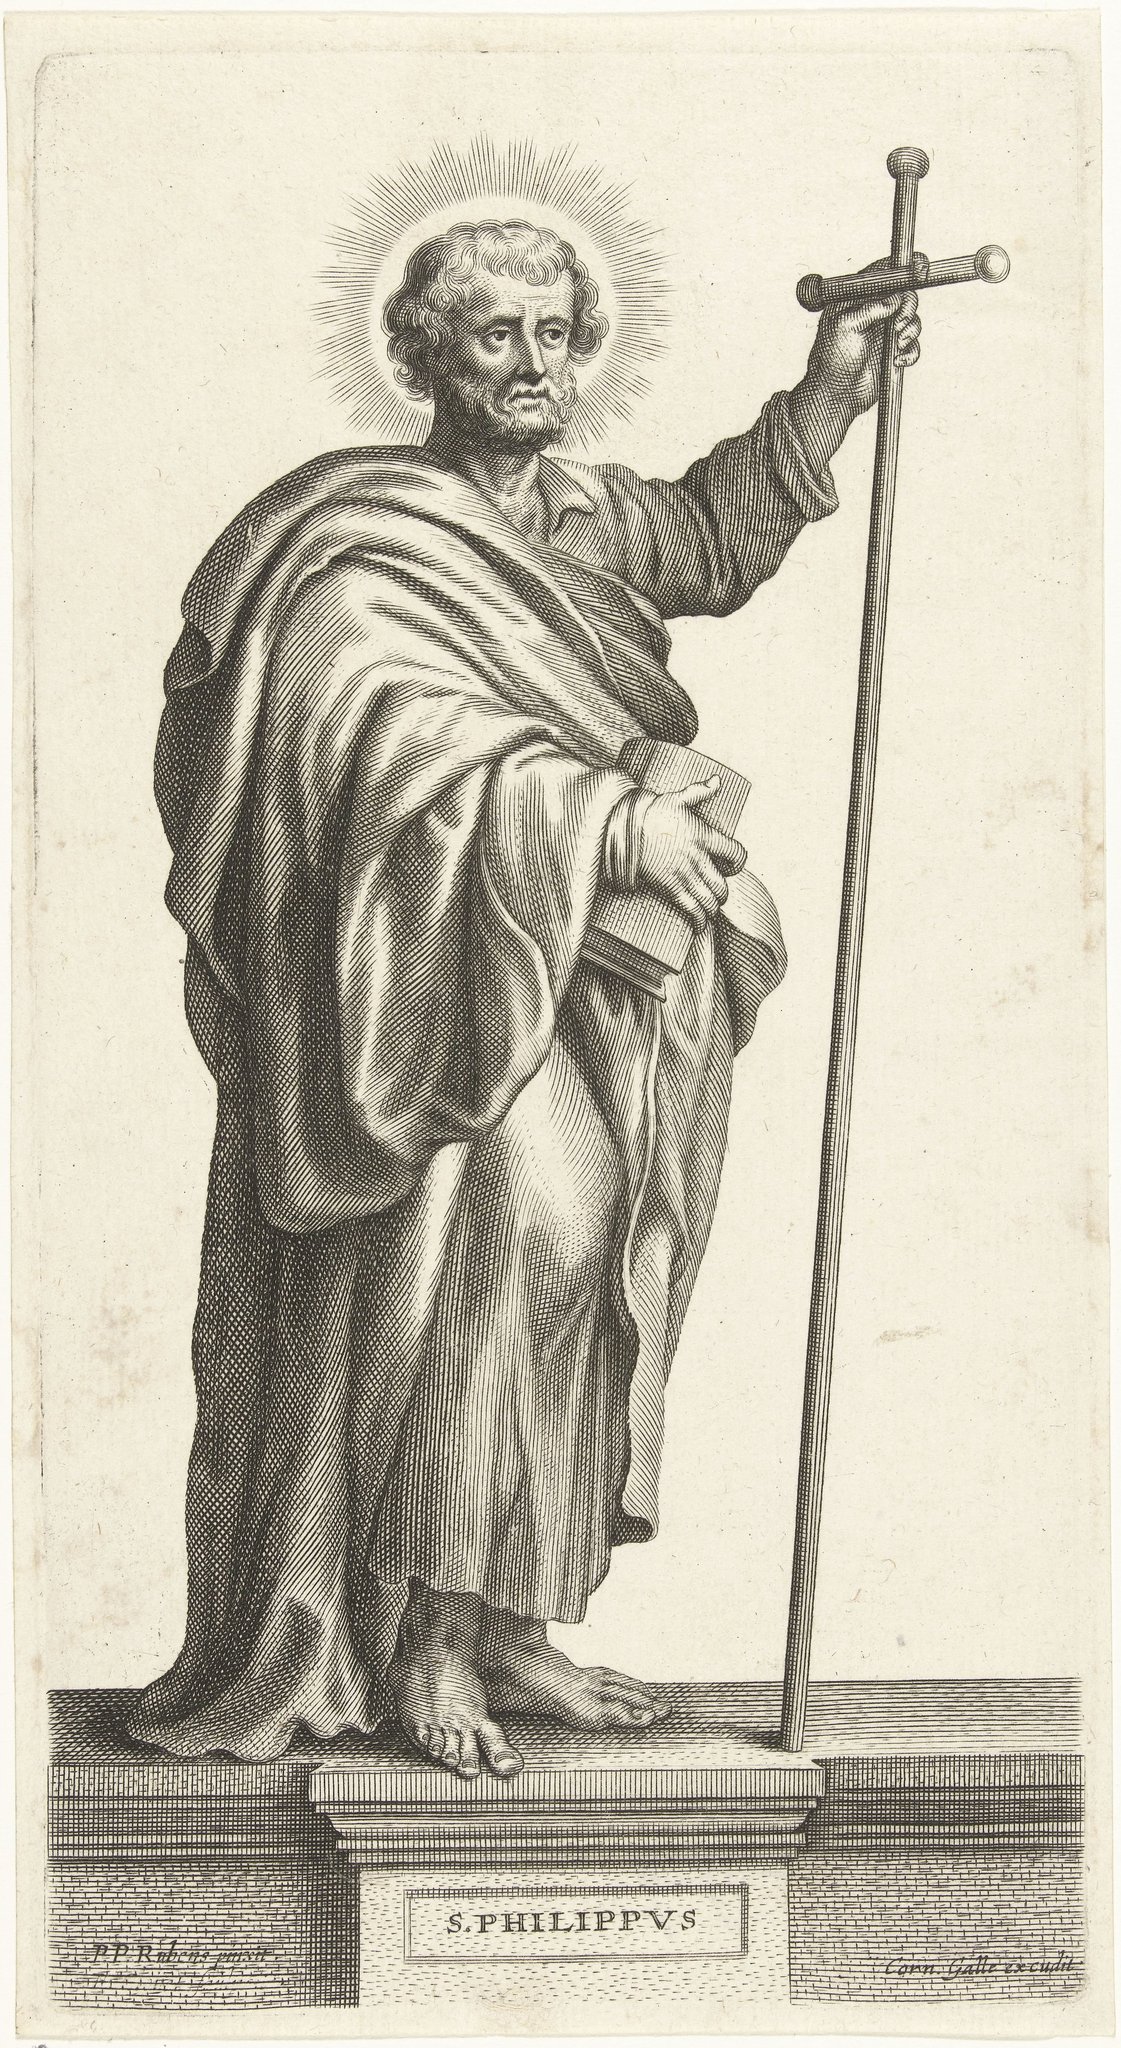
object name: print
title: Heilige Filippus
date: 1639-1670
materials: paper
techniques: engraving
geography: antwerp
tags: the apostle philip; possible attributes: book, cross, dish with snake, lance, scroll, stone, sword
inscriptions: collector's mark: Lugt 240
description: De prent toont de Heilige Filippus. In zijn linkerhand zijn martelwerktuig, het kruis. De serie bestaat uit prenten gebaseerd op schilderijen van Peter Paul Rubens.